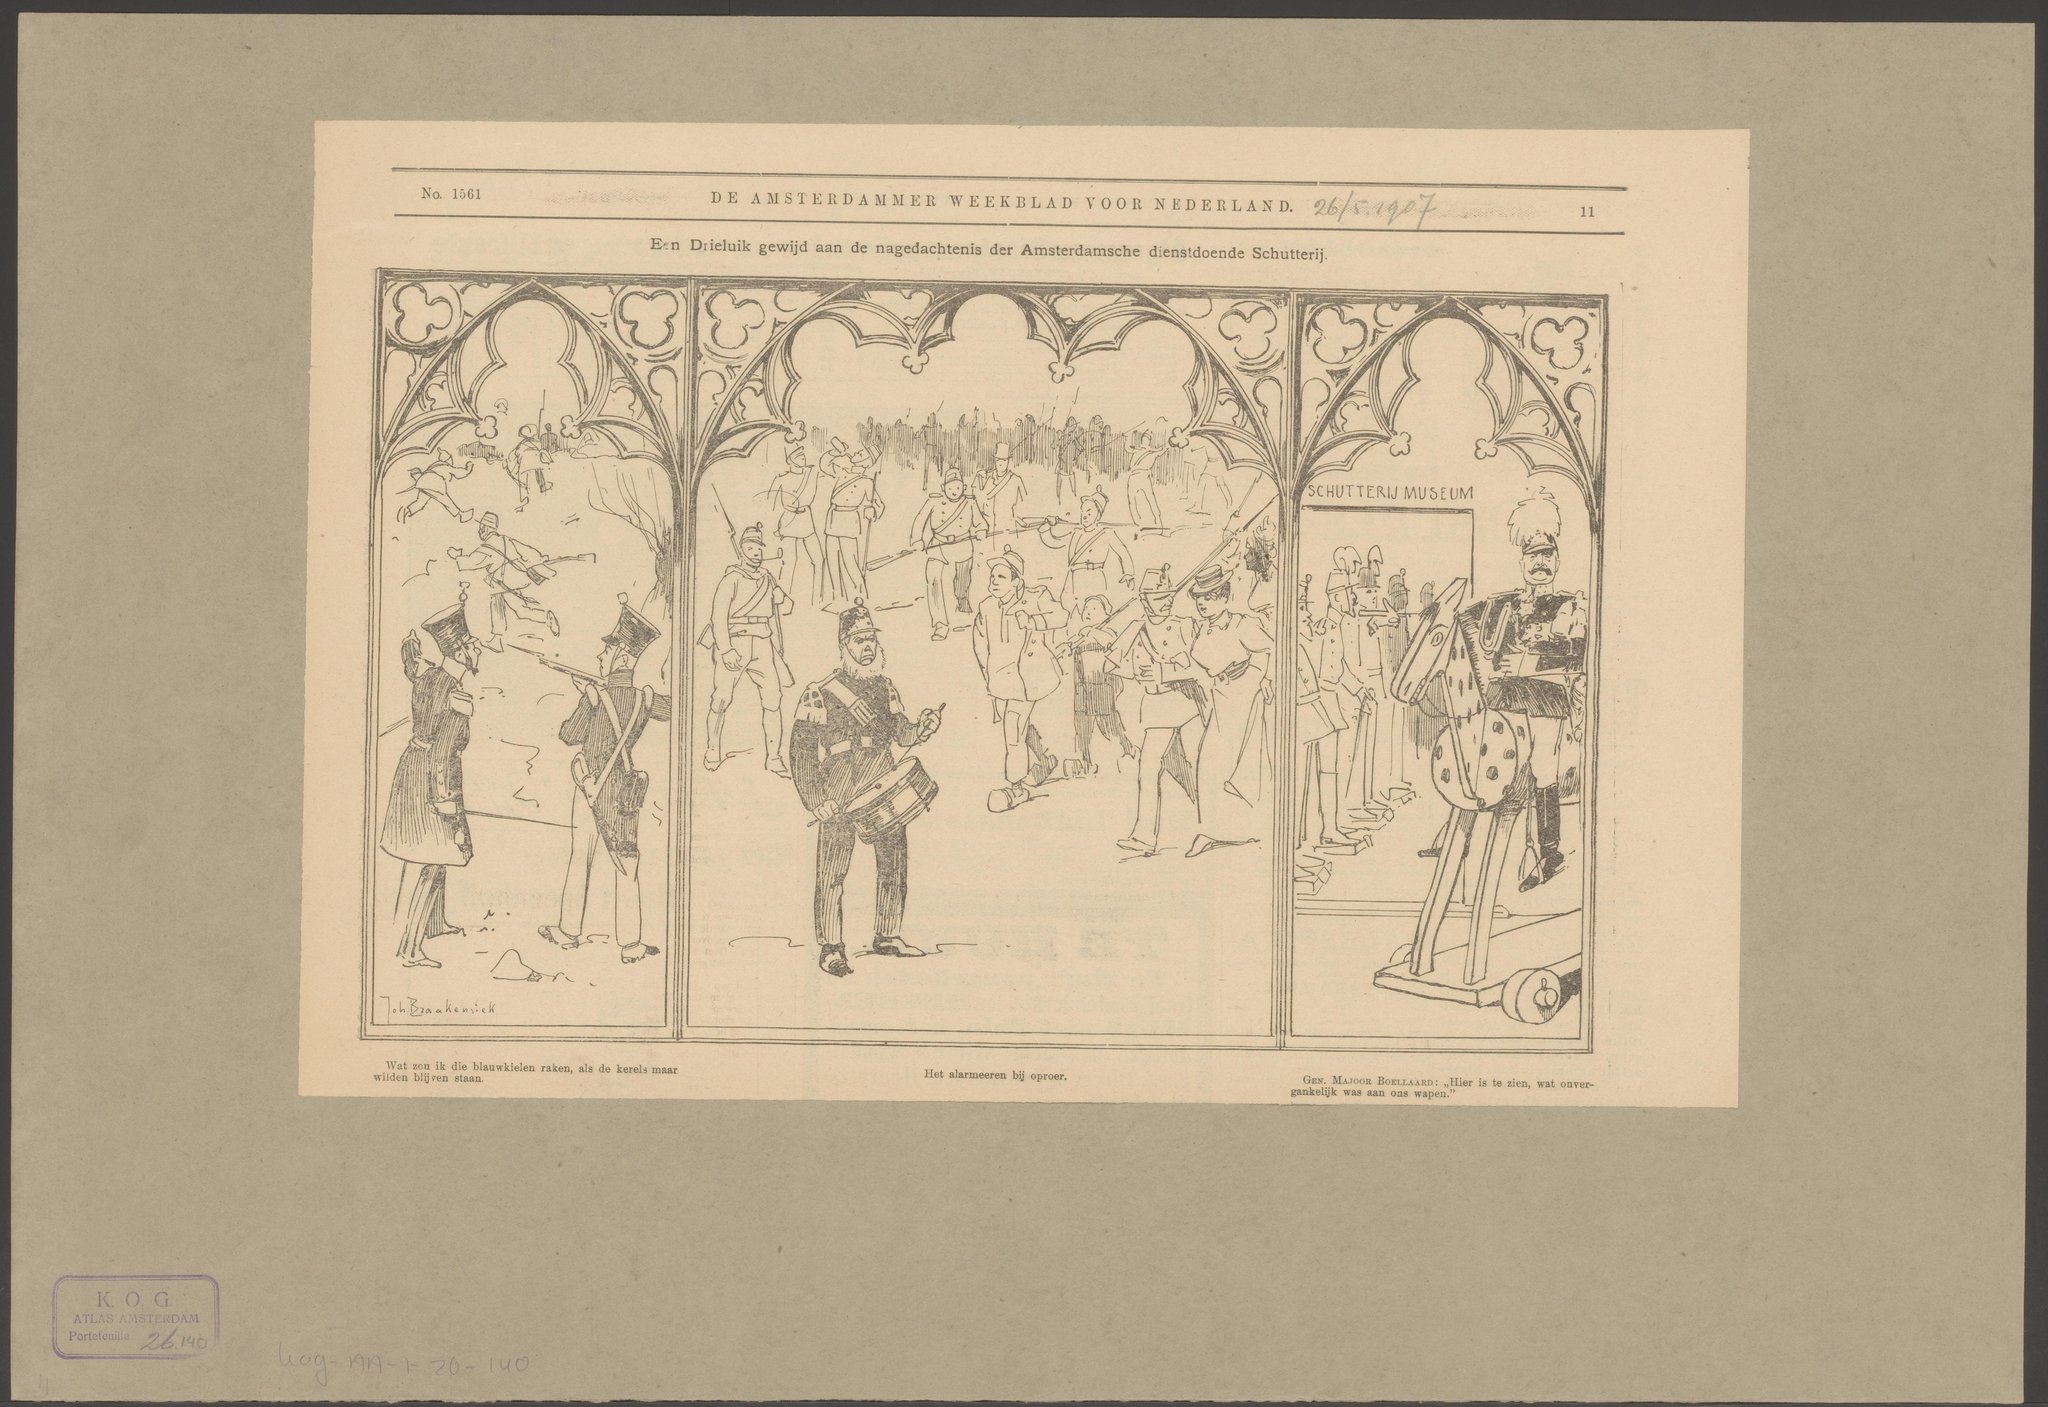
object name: photomechanical print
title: Een Drieluik gewijd aan de nagedachtenis der Amsterdamsche dienstdoende Schutterij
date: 1907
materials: paper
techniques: letterpress printing, line block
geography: netherlands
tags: politician, military service (+ citizen soldiery, civil guard, citizen militia), drum (musical instrument), firearms: rifle, rocking-horse, amsterdam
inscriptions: collector's mark: Lugt 1641b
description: Onderwerpsrubriek binnen de Atlas Amsterdam: Herinneringen aan de Schutterij.